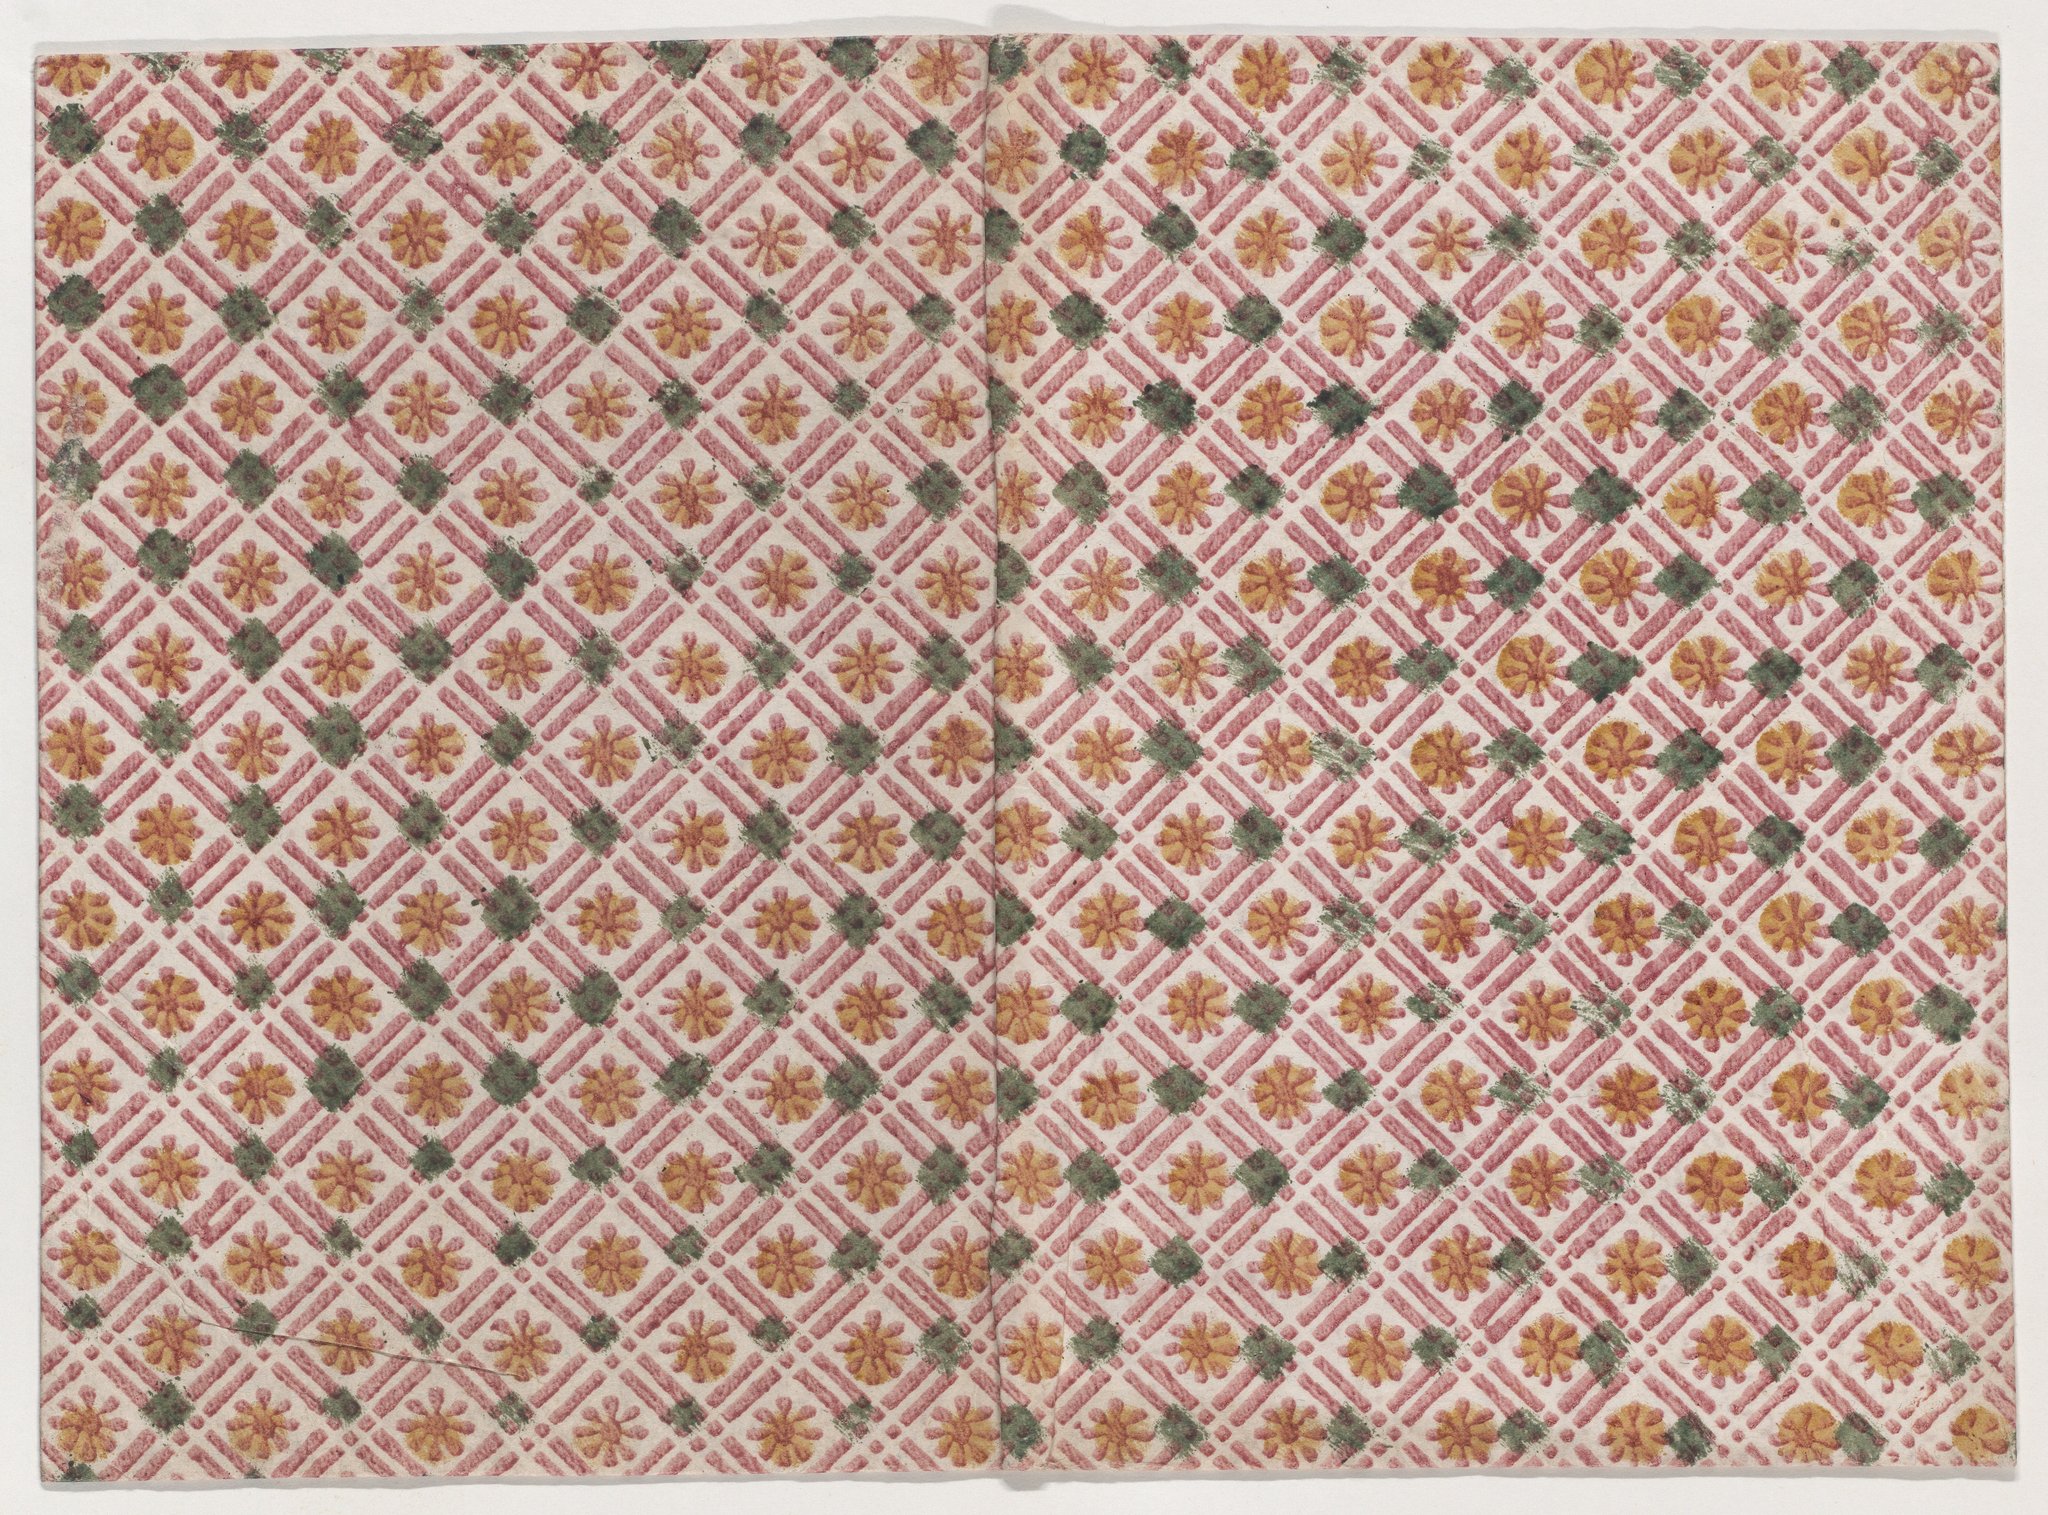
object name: print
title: Book cover with geometric and floral pattern in red, yellow, and green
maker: Anonymous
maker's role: artist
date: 1801-1900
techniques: relief print